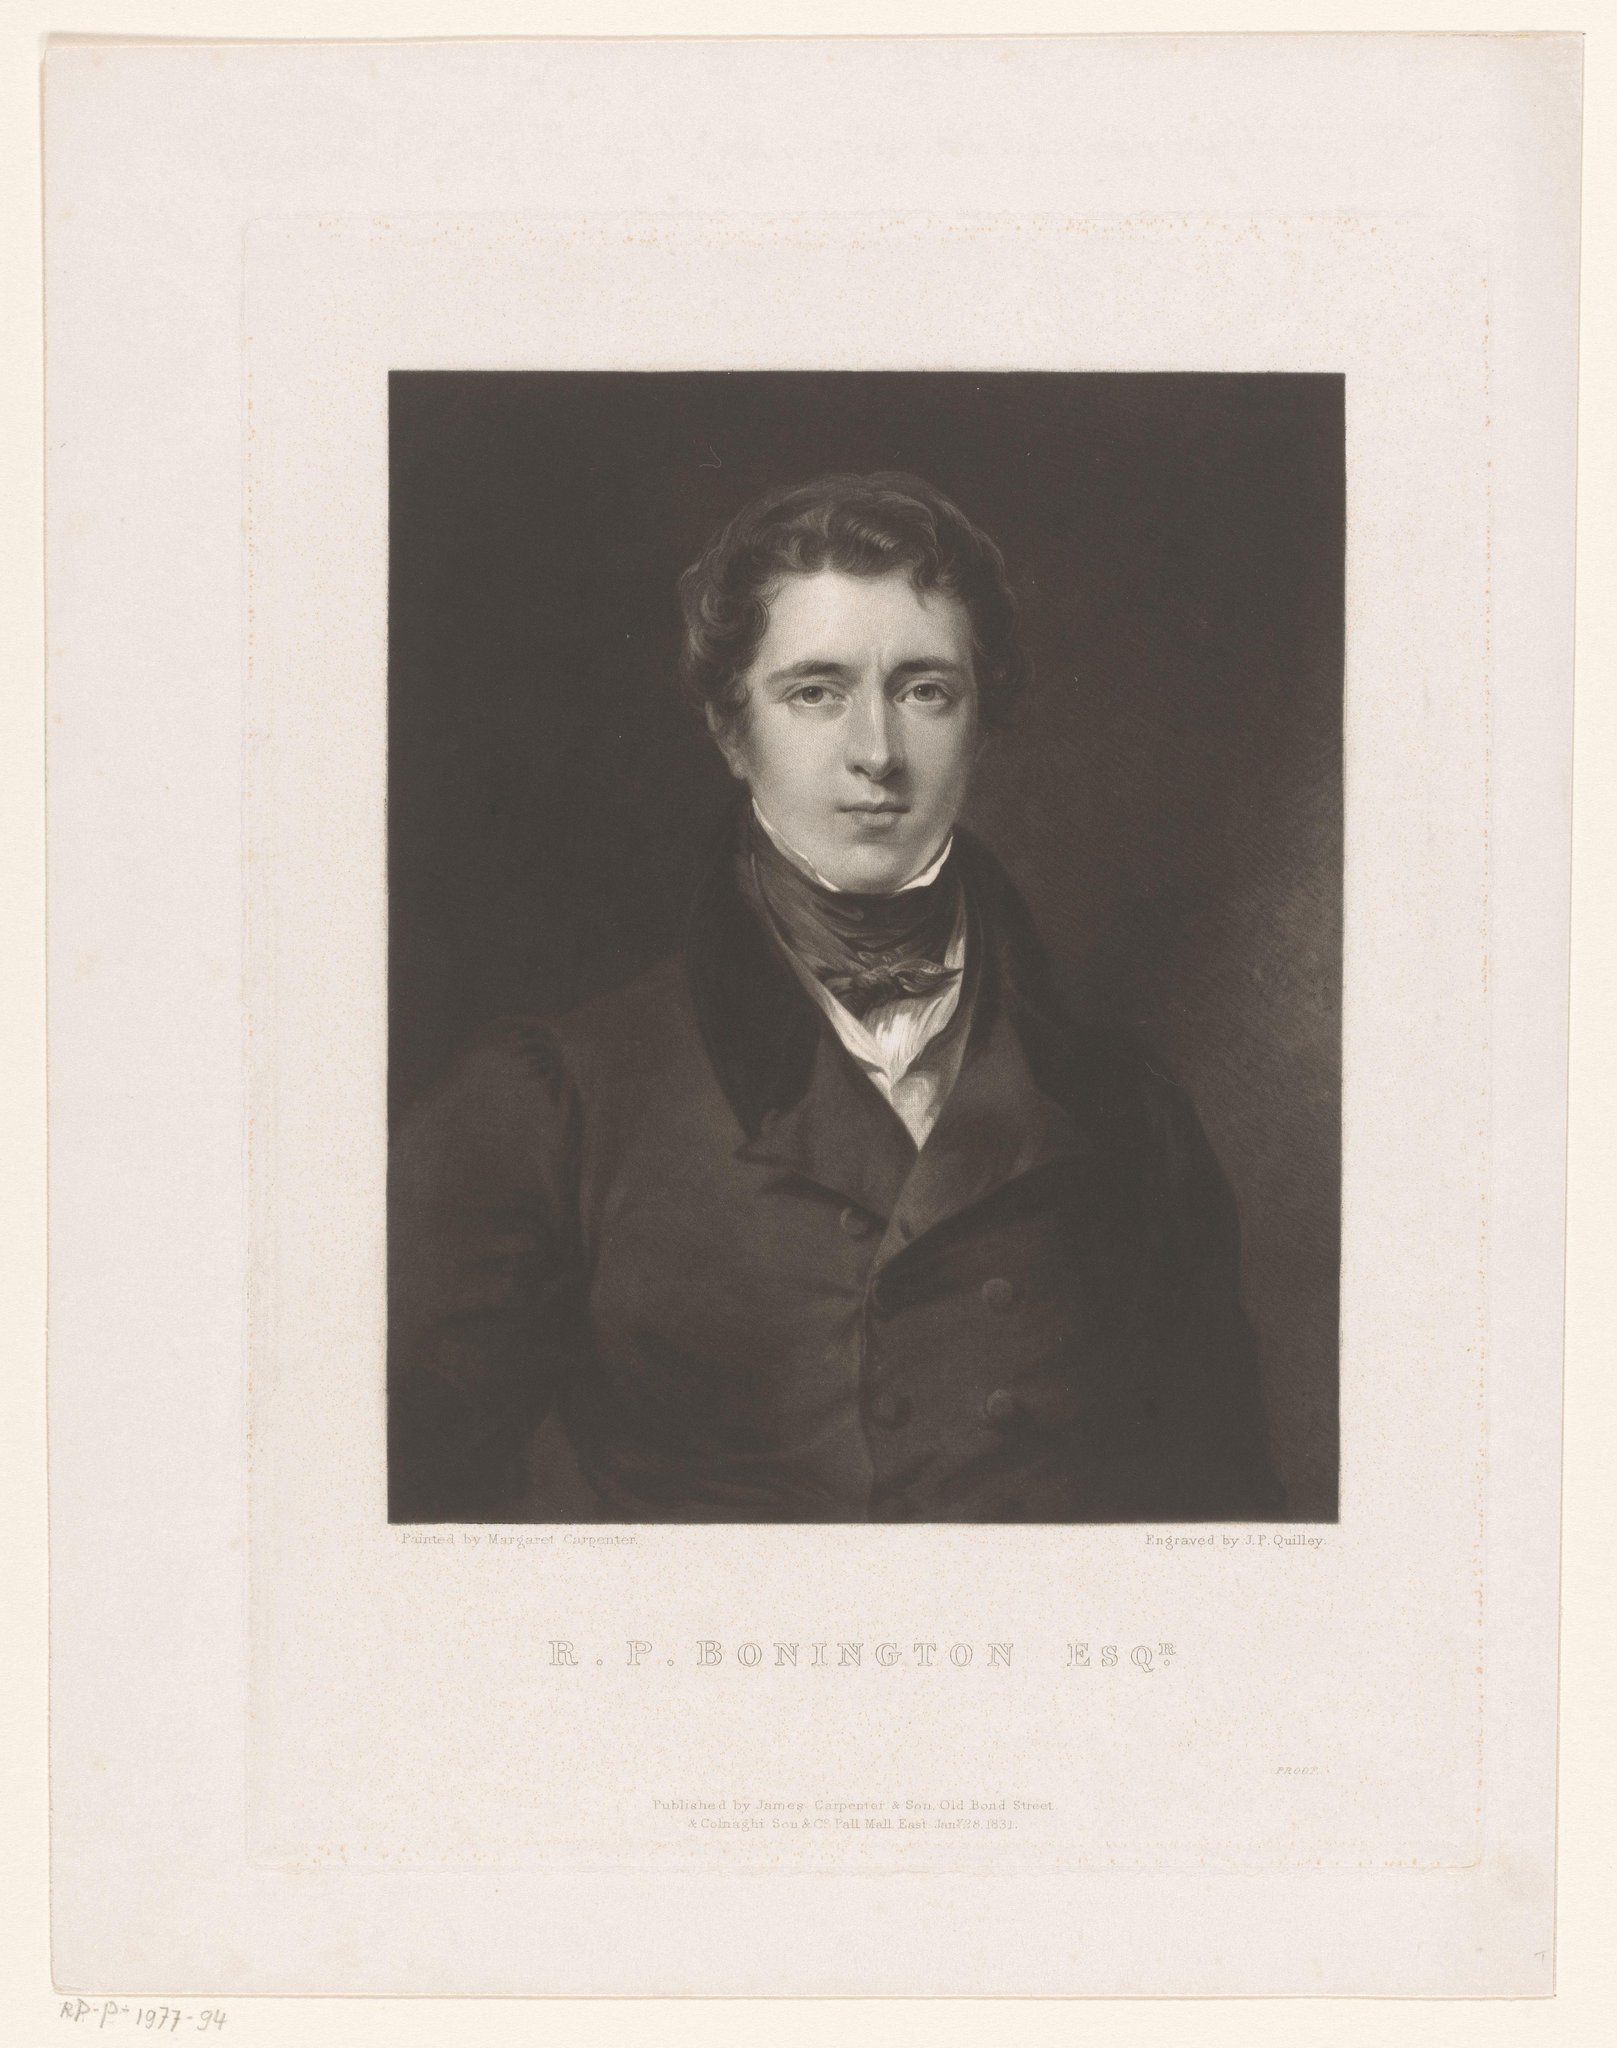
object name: print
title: Portret van Richard Parkes Bonington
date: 1831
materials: paper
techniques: mezzotint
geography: london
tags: london, painter, print maker, richard parkes bonington, historical persons, portrait, self-portrait of draughtsman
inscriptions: collector's mark: Lugt 2760, collector's mark: Lugt 2228